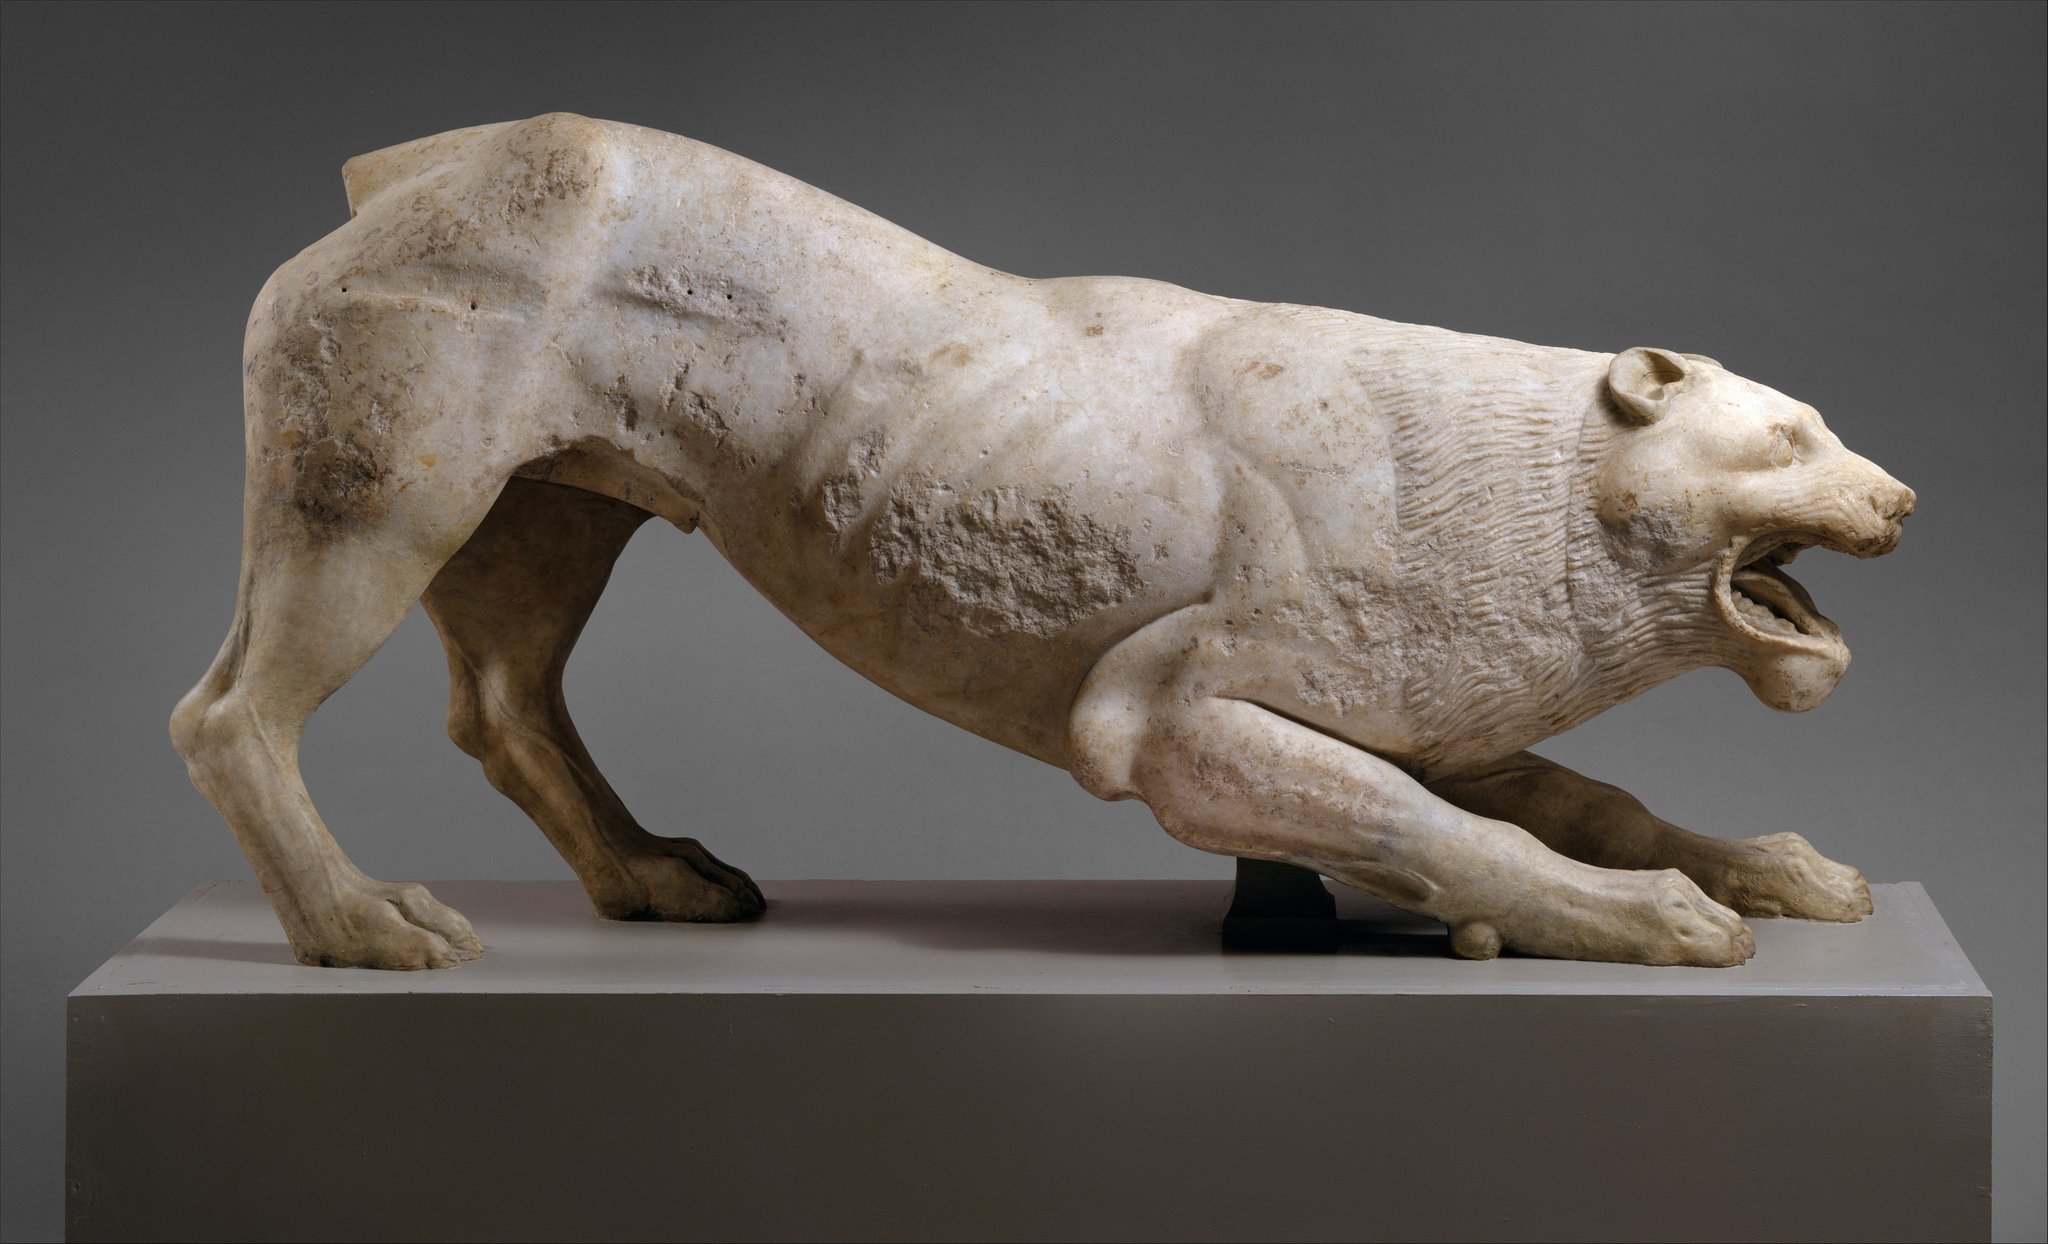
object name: statuette of a lion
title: Marble statue of a lion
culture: greek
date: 400-390 BCE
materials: marble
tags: lions